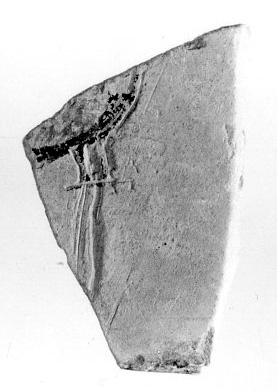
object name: relief fragment, tomb of meketre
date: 1981-1975 BCE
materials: limestone, paint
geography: egypt